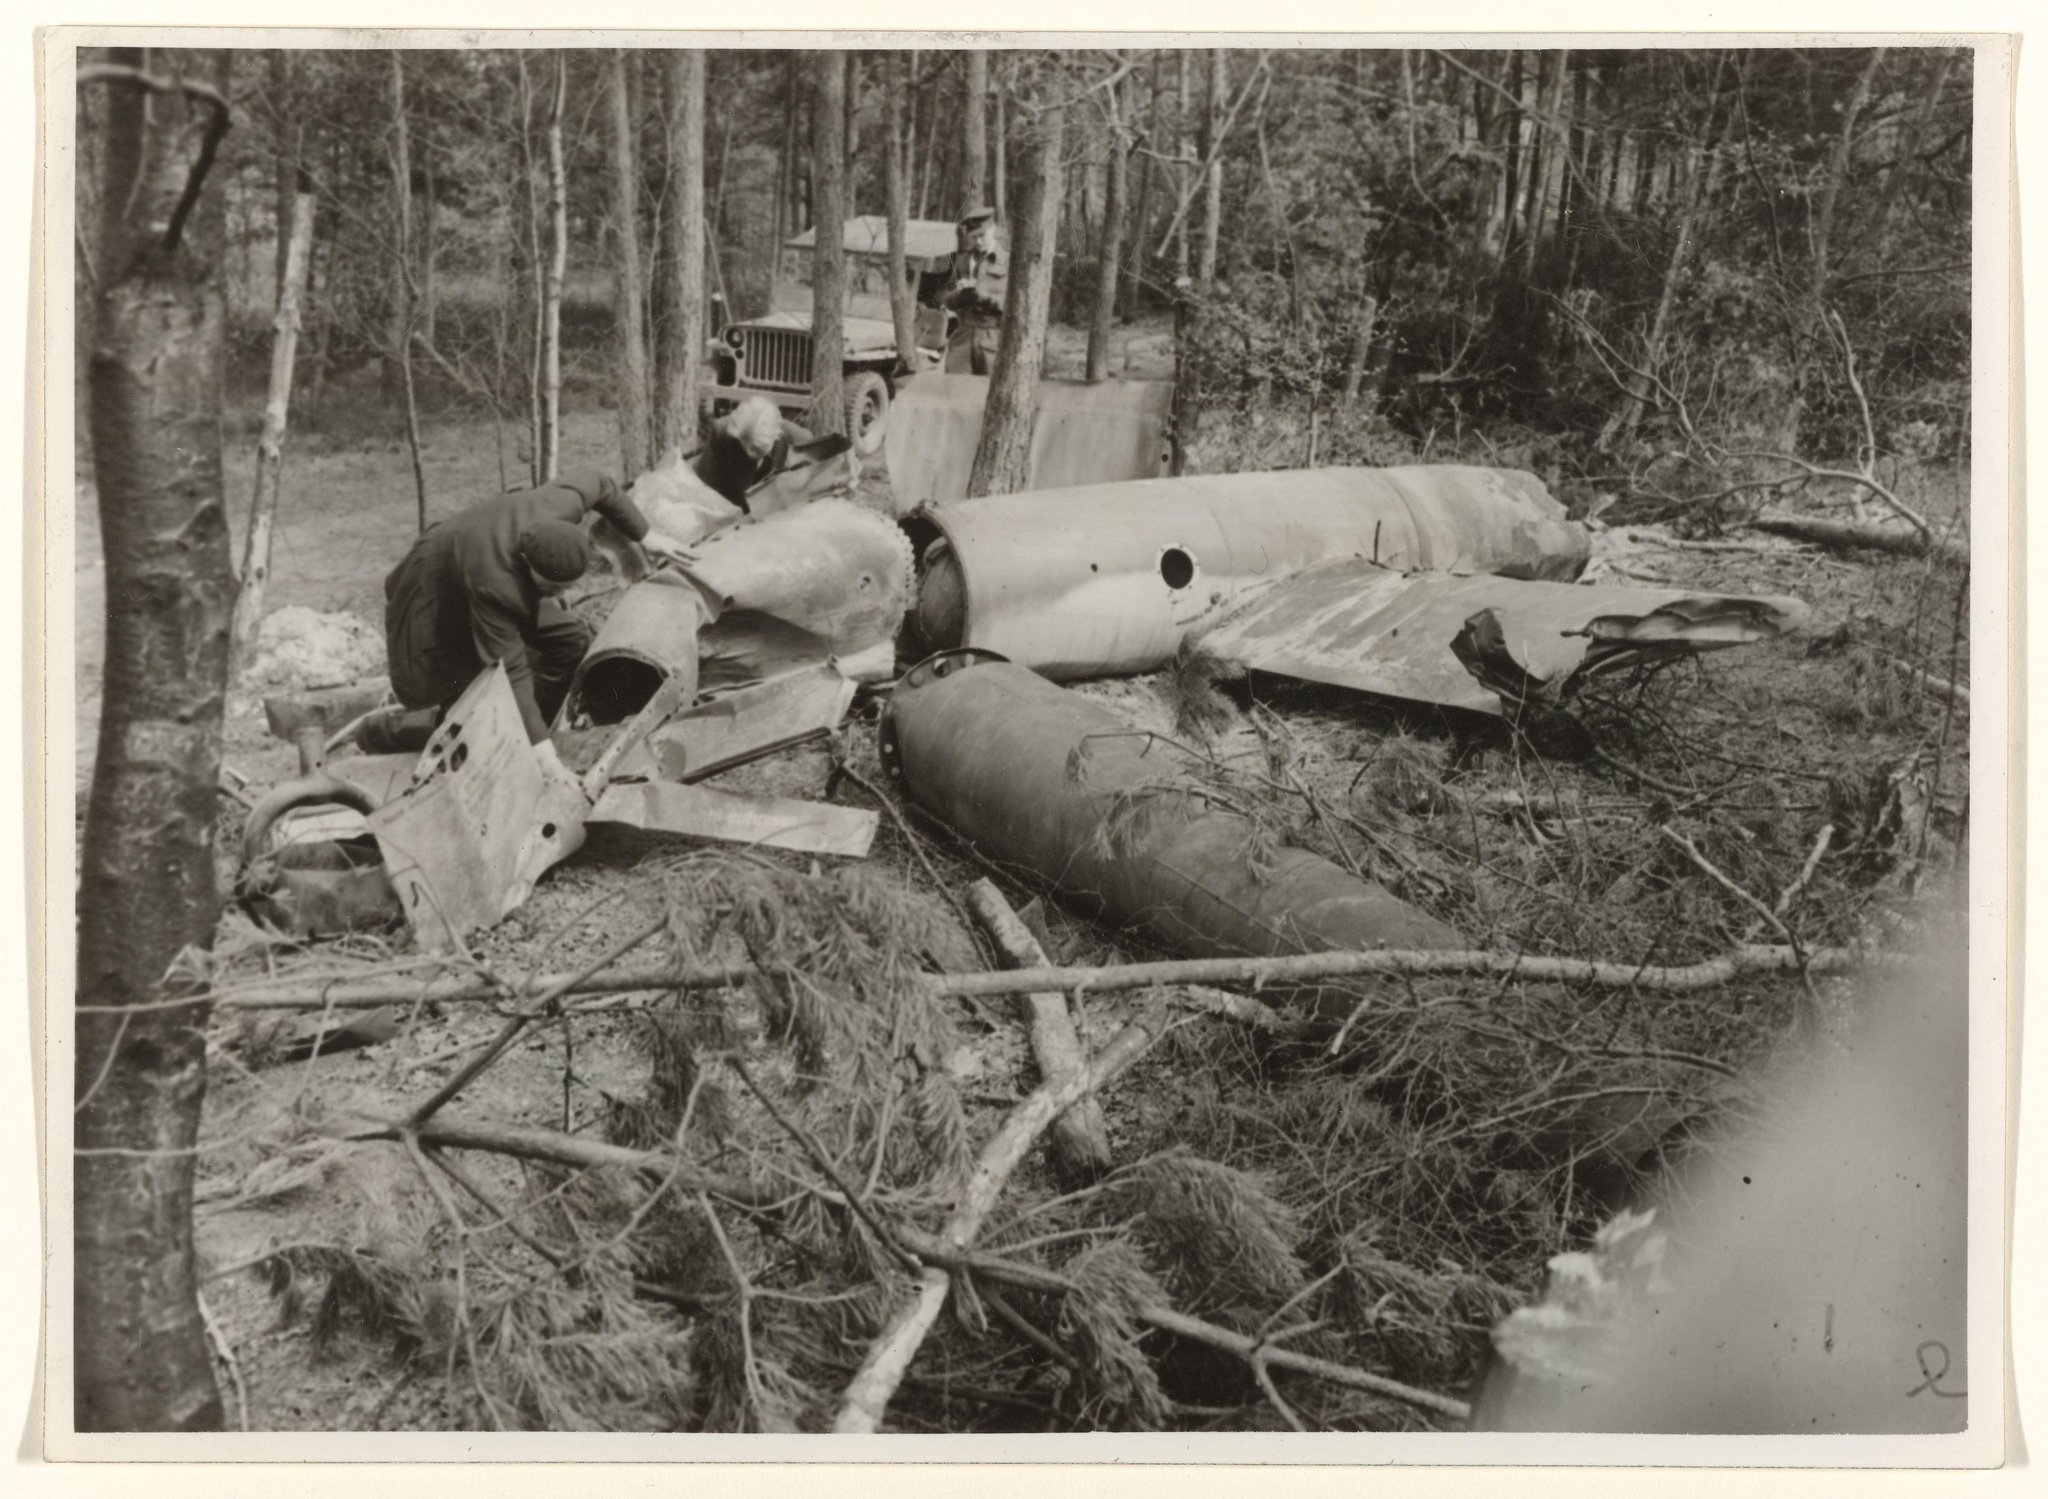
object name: documentary photograph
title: Neergestortte V-1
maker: Anonymous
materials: photographic support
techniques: photography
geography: almelo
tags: almelo, bevrijding van nederland (1945)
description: Een bom is neergestort op enkele tientallen meters van de lanceerplaats. Deze V-1 was bestemd voor Antwerpen.